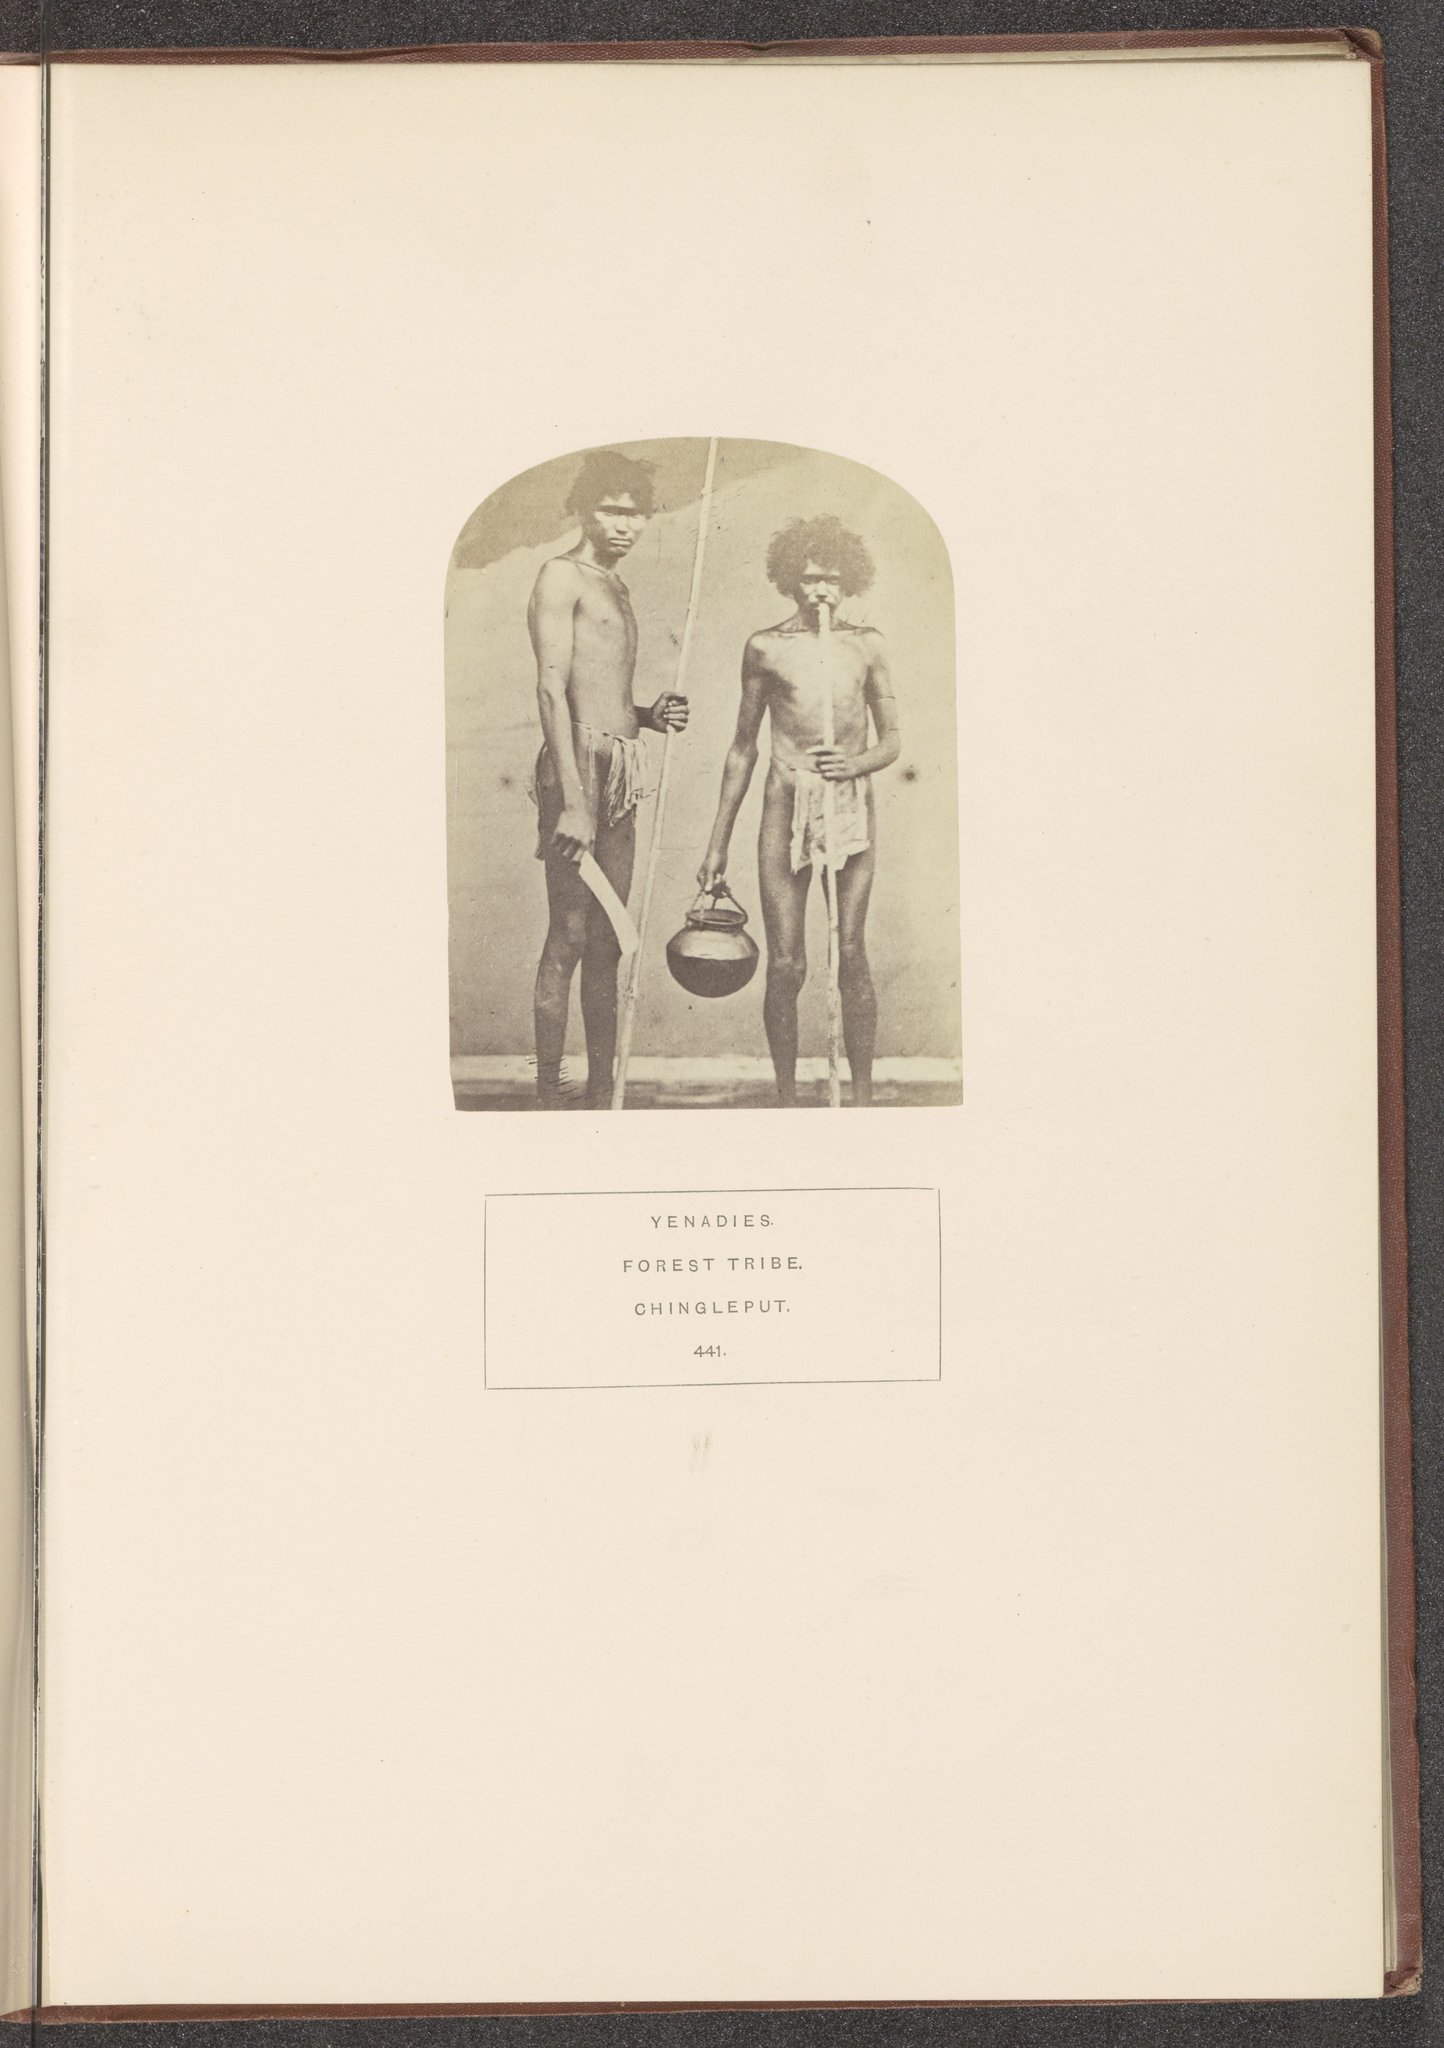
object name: page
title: Portrait of two unknown men from the Yenadi tribe with a pot, knife and sticks, Chengalpattu, Tamil Nadu, India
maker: Anonymous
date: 1865-1875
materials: photographic support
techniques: albumen print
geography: chengalpattu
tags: human races; peoples; nationalities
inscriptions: number: ‘441.’, inscription: ‘YENADIES./ FOREST TRIBE./ CHINGLEPUT.’